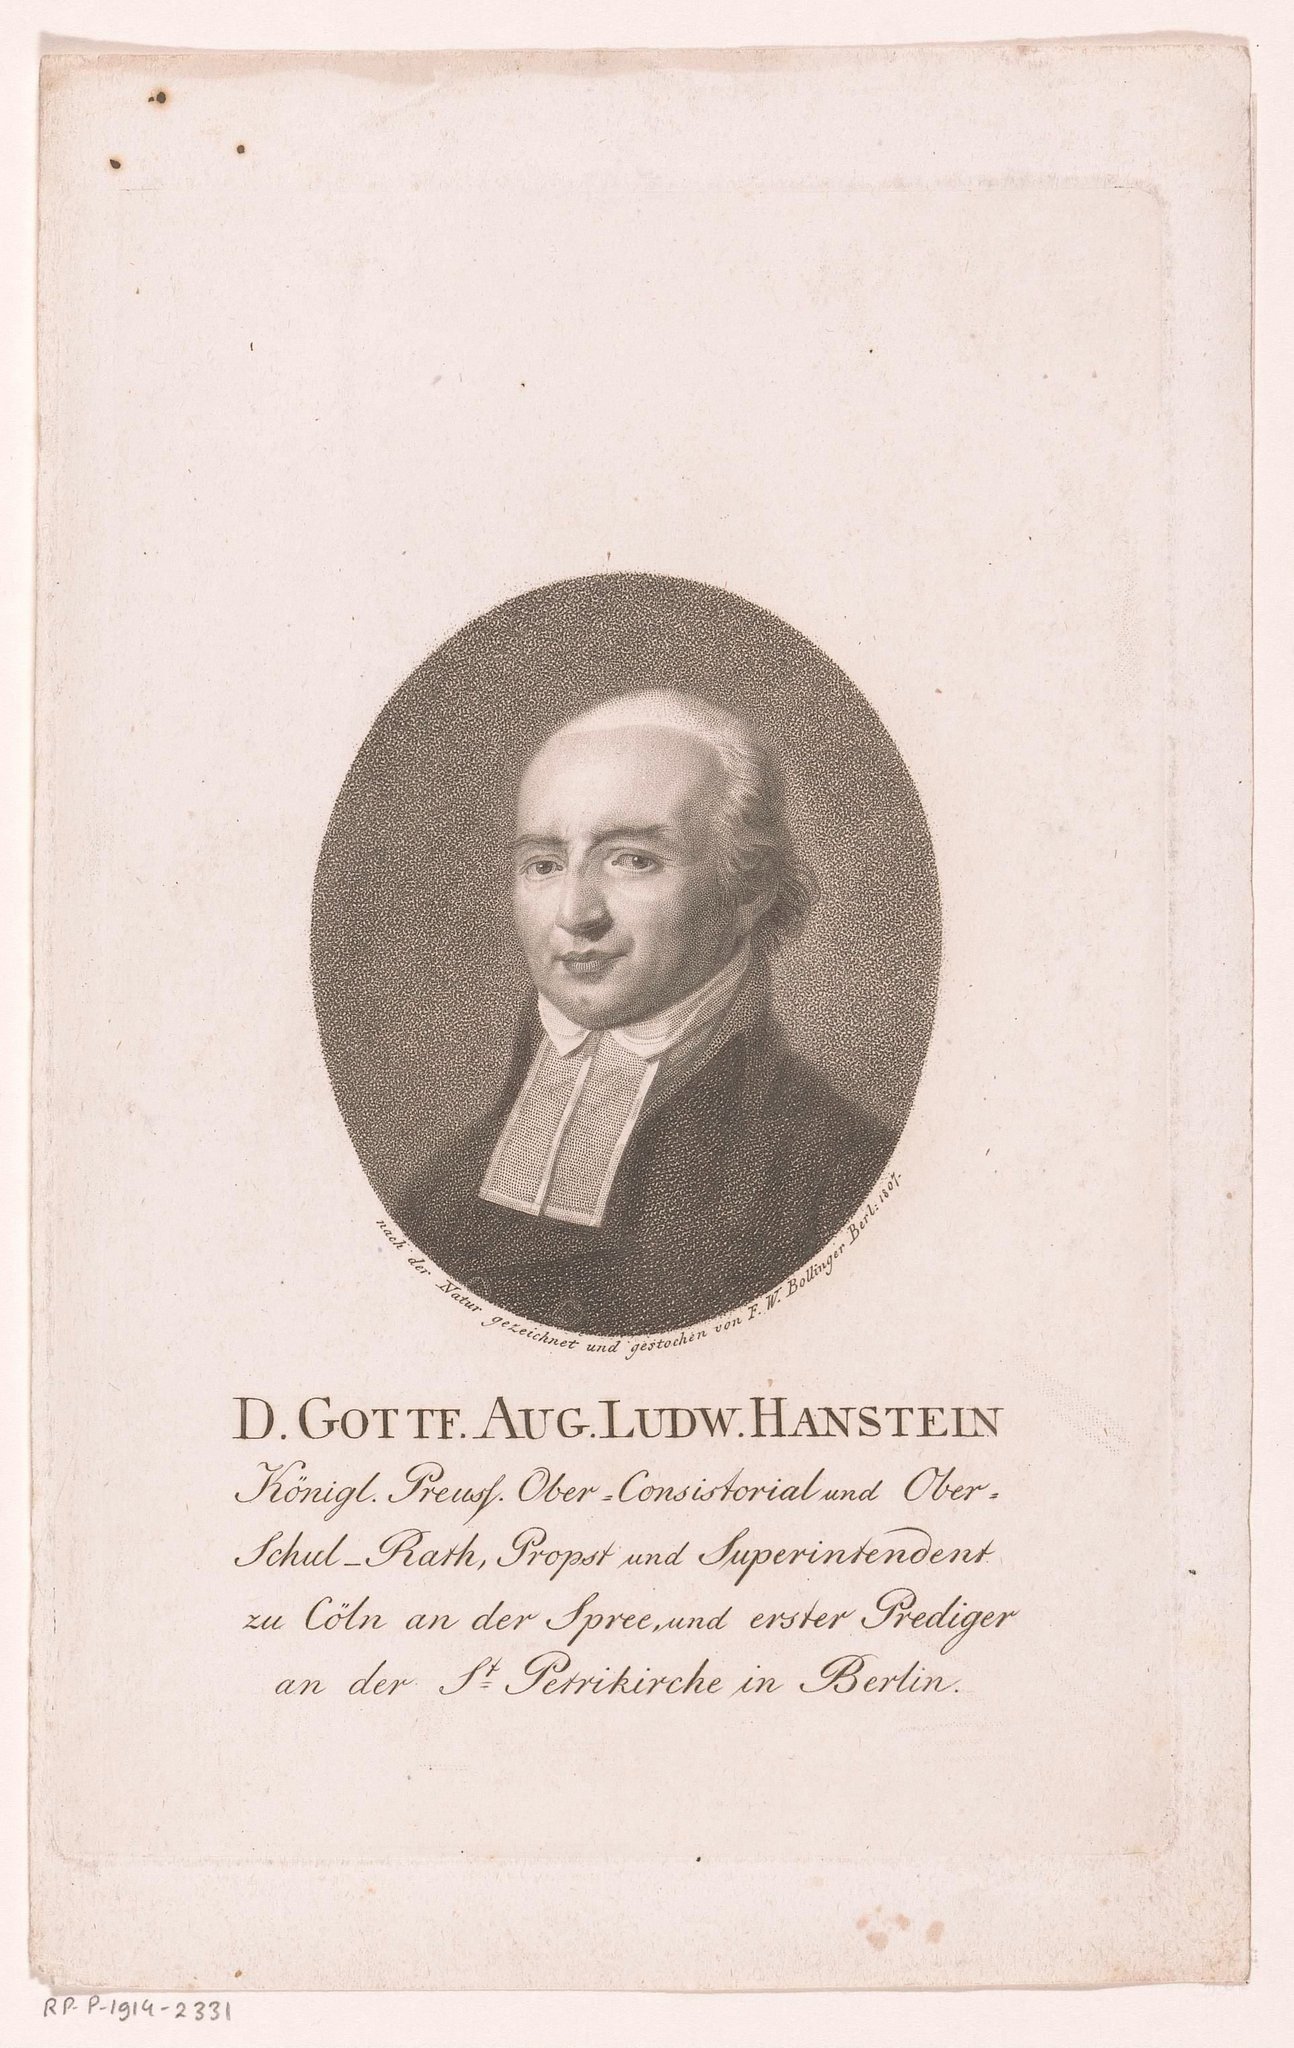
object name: print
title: Portret van Gottfried August Ludwig Hanstein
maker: friedrich wilhelm bollinger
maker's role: print maker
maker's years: 1777-1825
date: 1807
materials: paper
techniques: stippling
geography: berlin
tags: berlin, historical persons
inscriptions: collector's mark: Lugt 2228